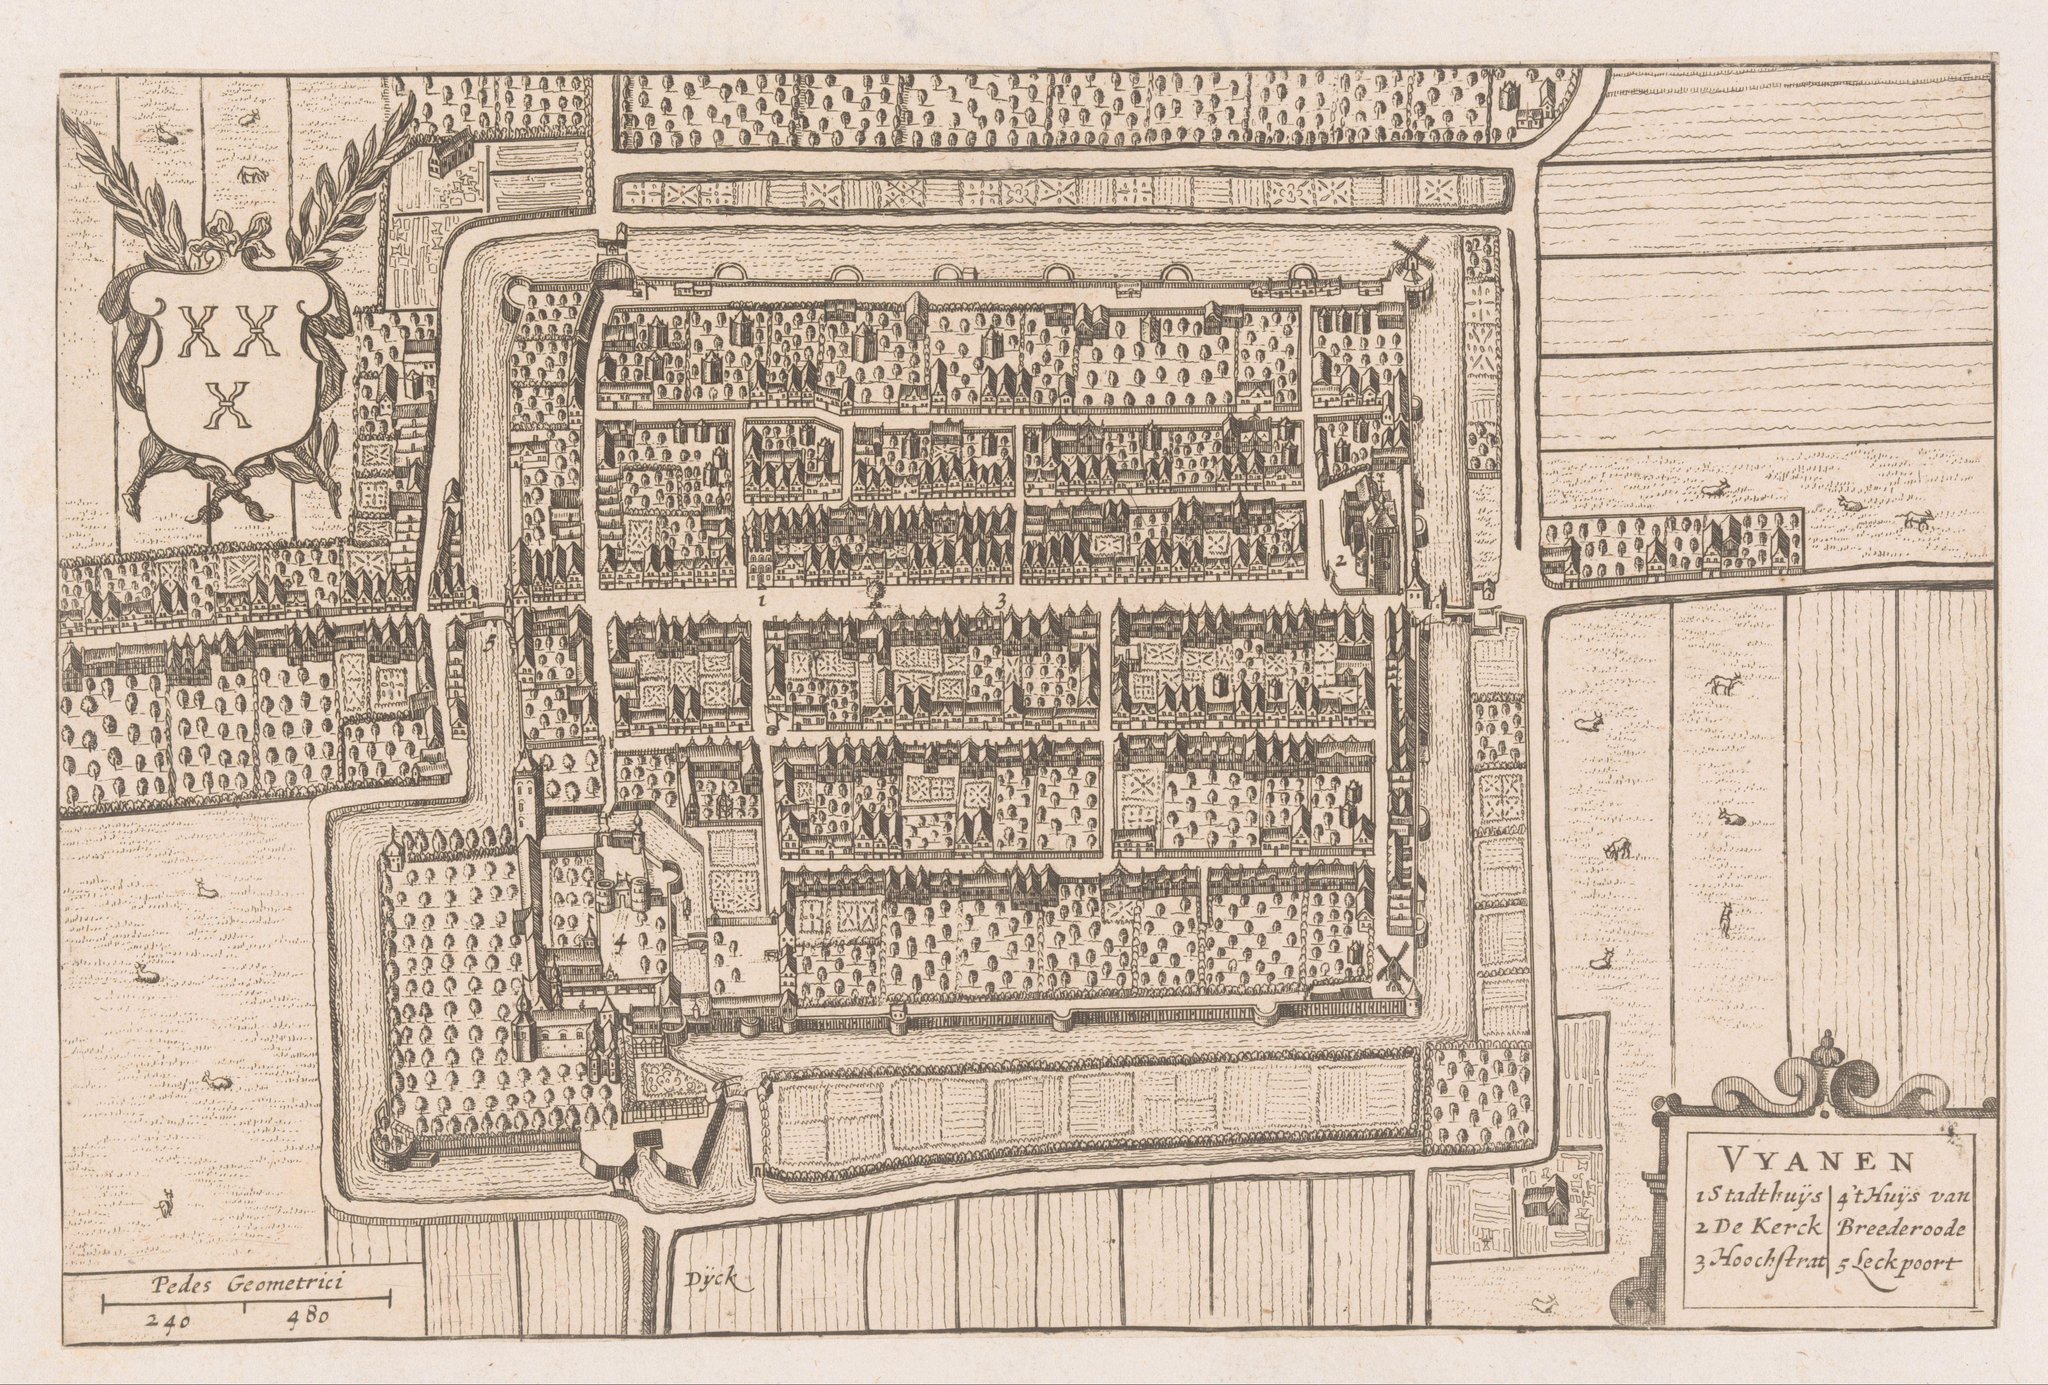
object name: print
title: Vyanen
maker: Anonymous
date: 1632-1652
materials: paper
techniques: etching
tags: maps of cities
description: Prent gebruikt in: Boxhorn, Marcus Zuerius van. Theatrum sive Hollandiae comitatus et urbium nova descriptio (…). Amsterdam: Henricus Hondius, 1632.